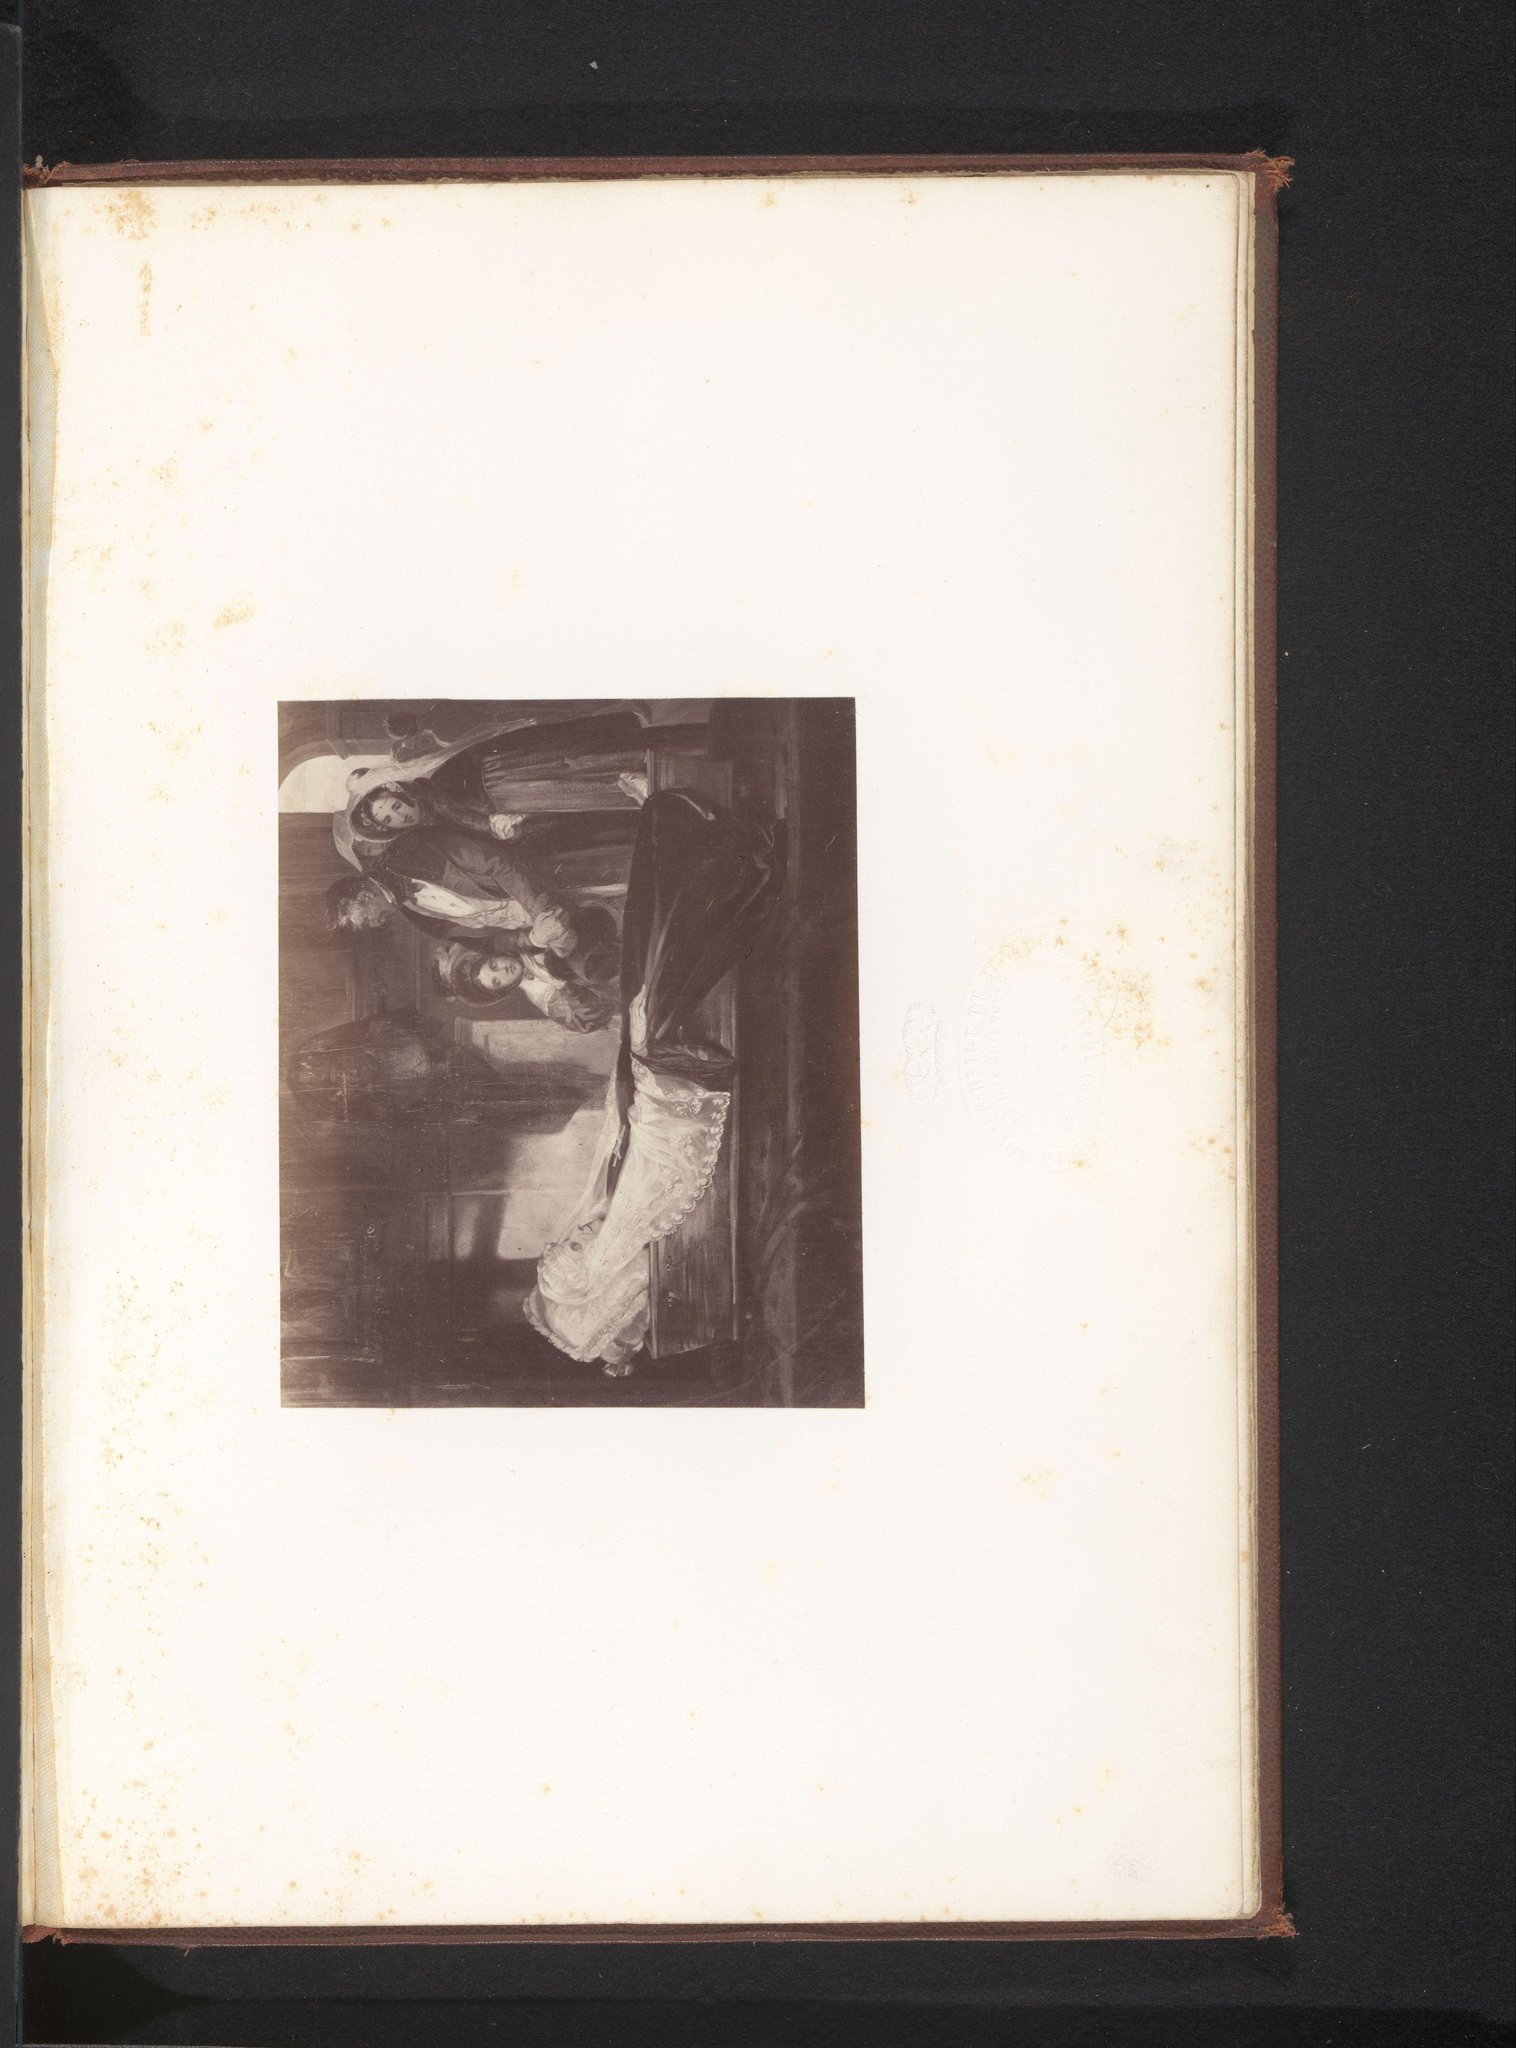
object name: page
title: Fotoreproductie van Laetitia Bonaparte op haar doodsbed door Antoine Wiertz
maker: edmond fierlants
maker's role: fotograaf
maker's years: 1819-1869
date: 1863-1868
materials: photographic support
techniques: albumen print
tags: deathbed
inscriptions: check stamp: ‘SOCIÉTÉ ROYALE BELGE DE PHOTOGRAPHIE/ 69, RUE KEYENVELD/ BRUXELLES’